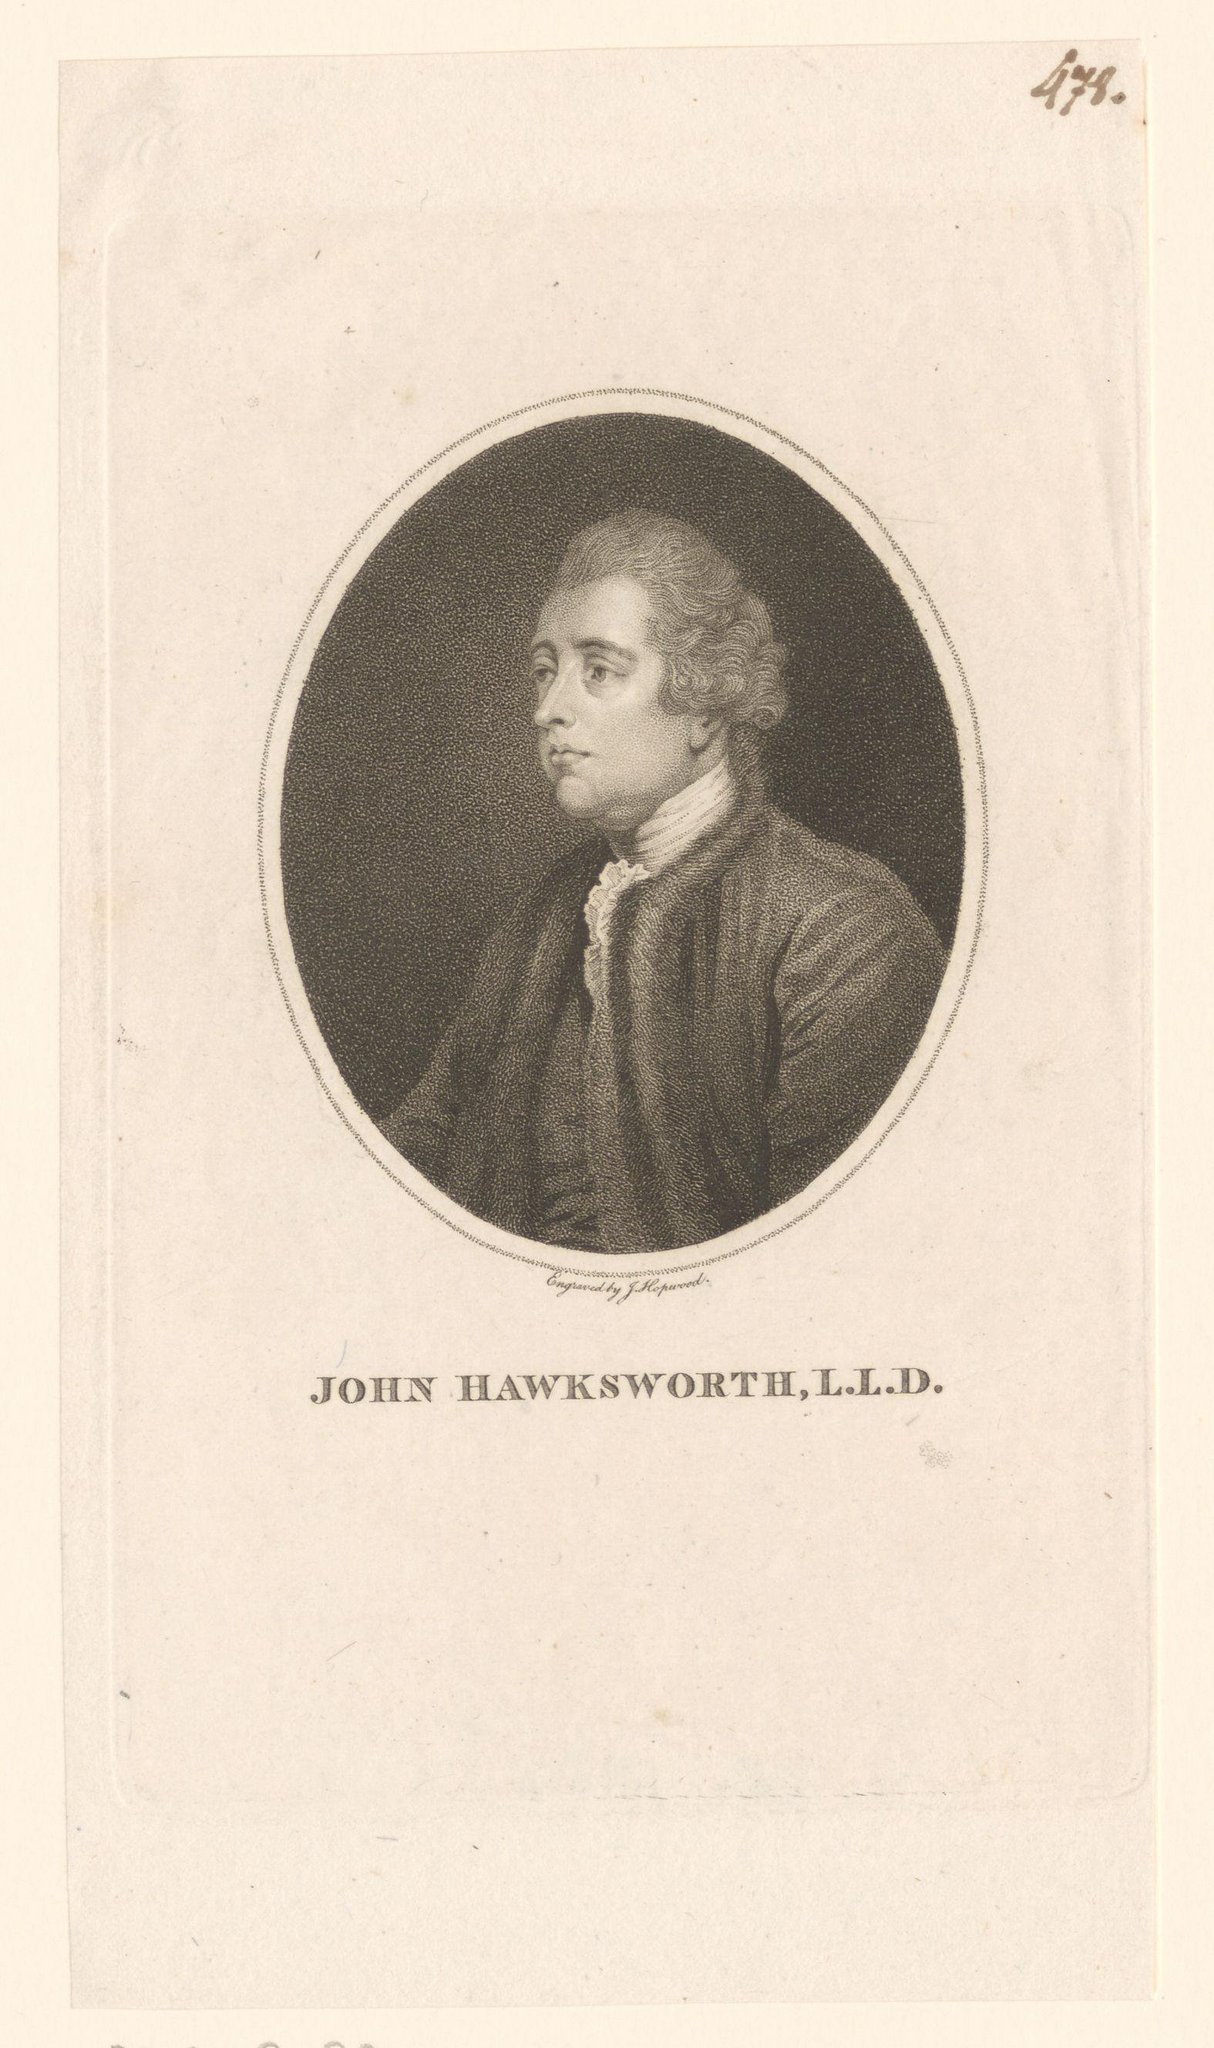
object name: print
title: Portret van John Hawkesworth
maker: james hopwood (i)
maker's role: print maker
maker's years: 1752-1819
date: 1762-1819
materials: paper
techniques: etching, engraving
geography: england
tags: london, historical persons, portrait of a writer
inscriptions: collector's mark: Lugt 2228, inscription: ‘478’